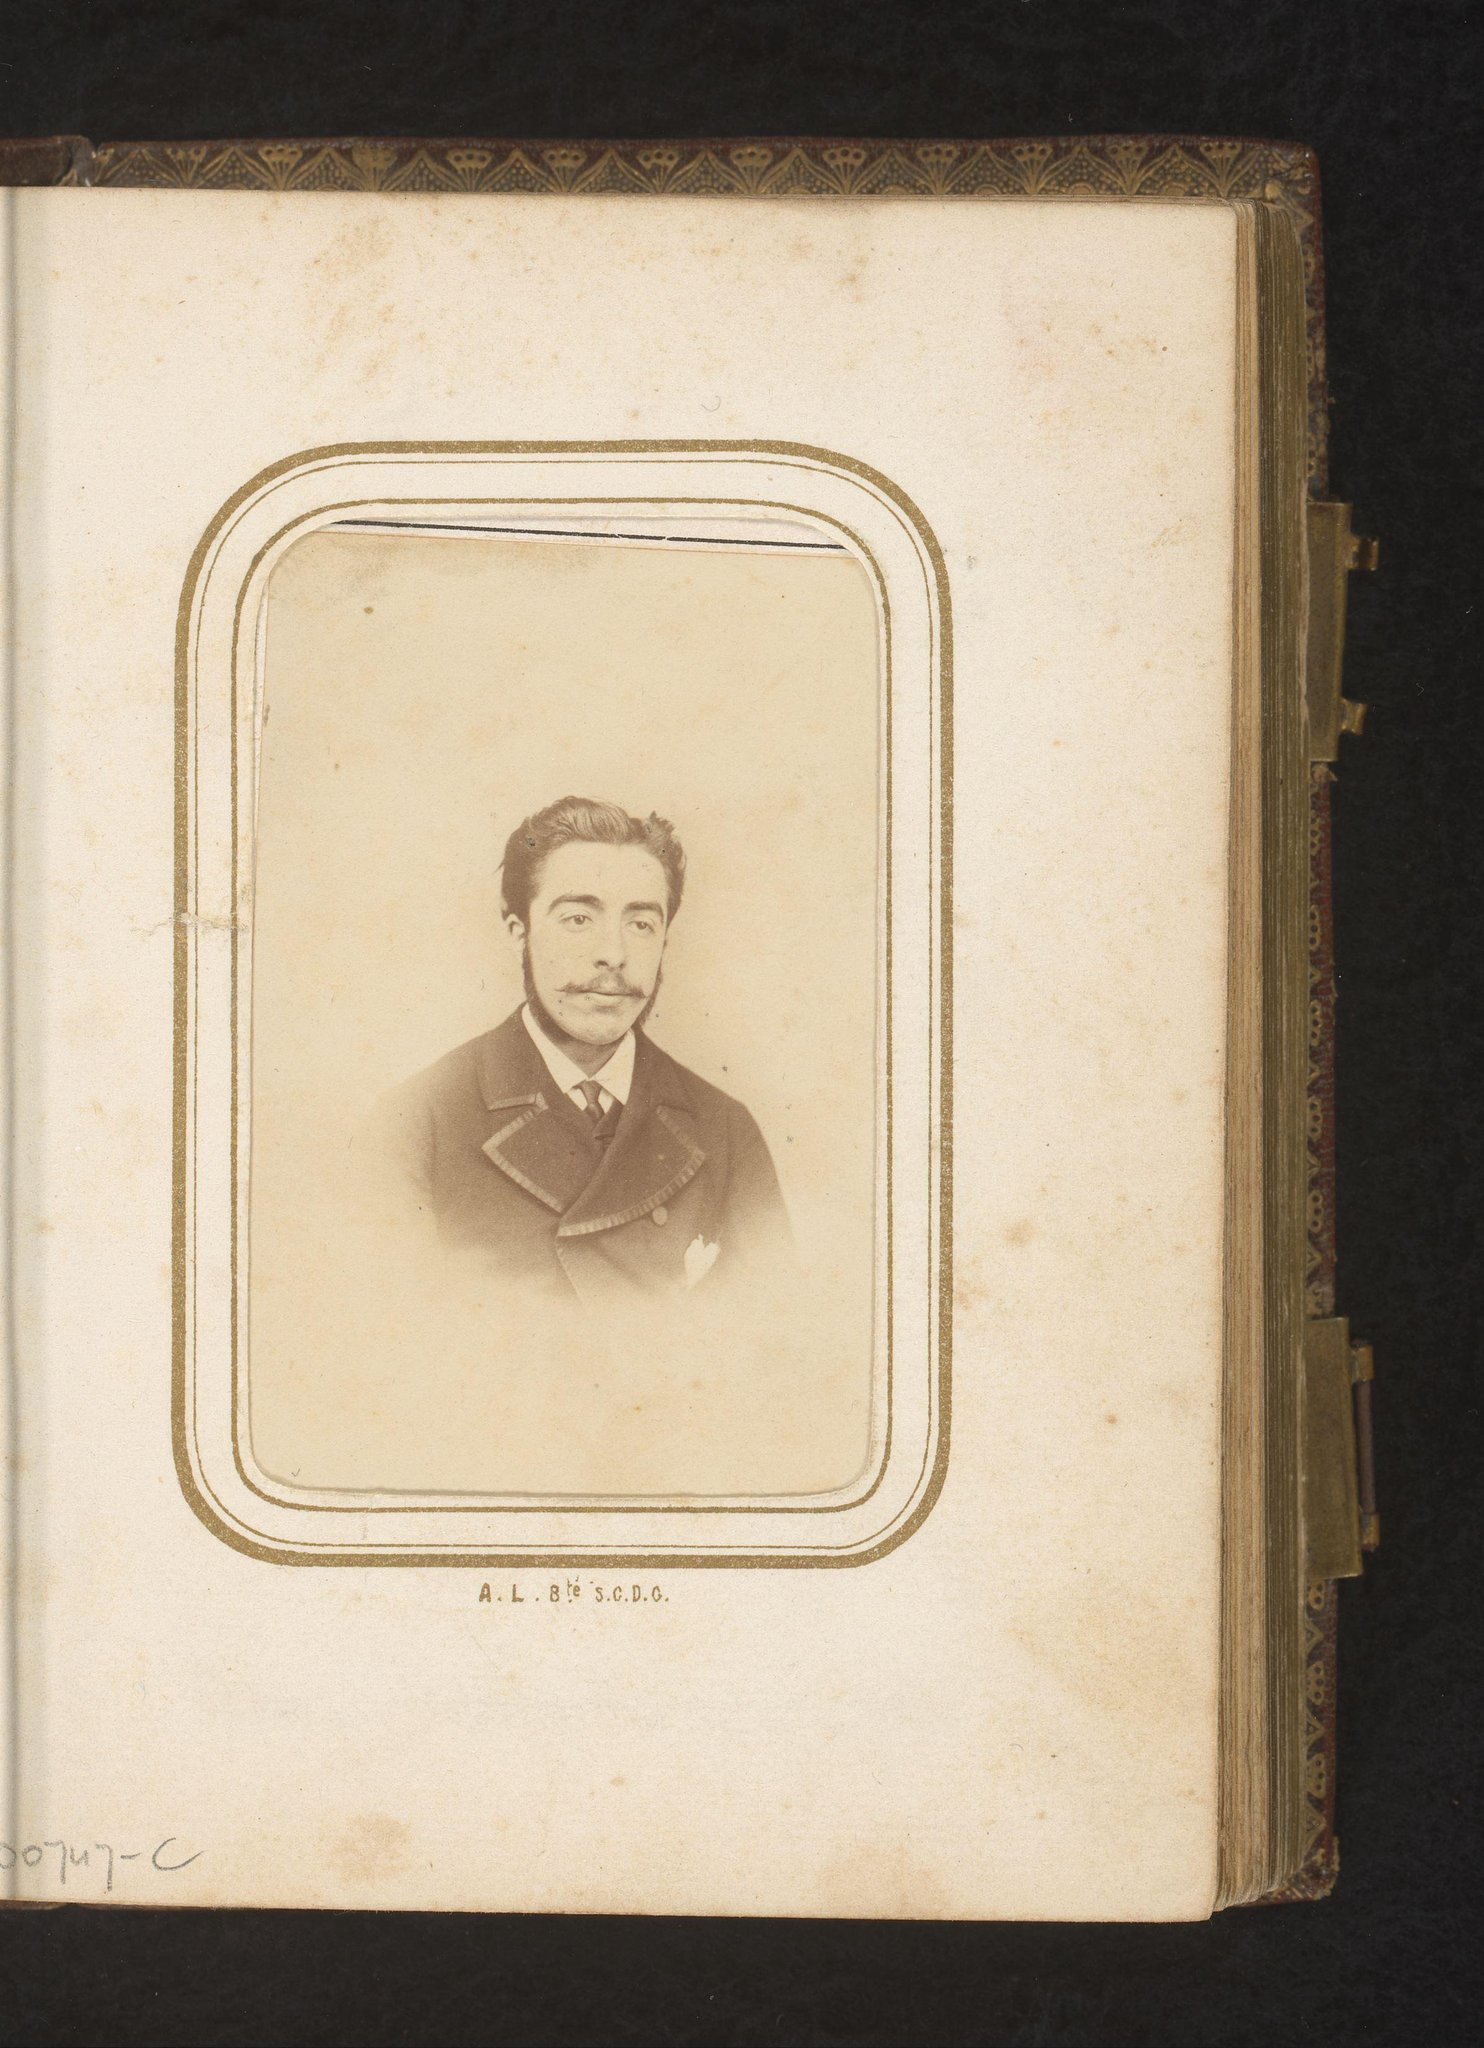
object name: photograph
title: Portret van een man met een snor en bakkebaarden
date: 1855-1870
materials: cardboard, photographic support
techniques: albumen print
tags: sideburns, moustache, adult man, historical persons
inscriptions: annotation: ‘Una prueba verdadera de canriño./ J. Herran’, inscription: ‘S. GErmain y Ca./ 29 Fuencarral, 29/ Madrid’, inscription: ‘A.L. B.te S.C.D.G.’